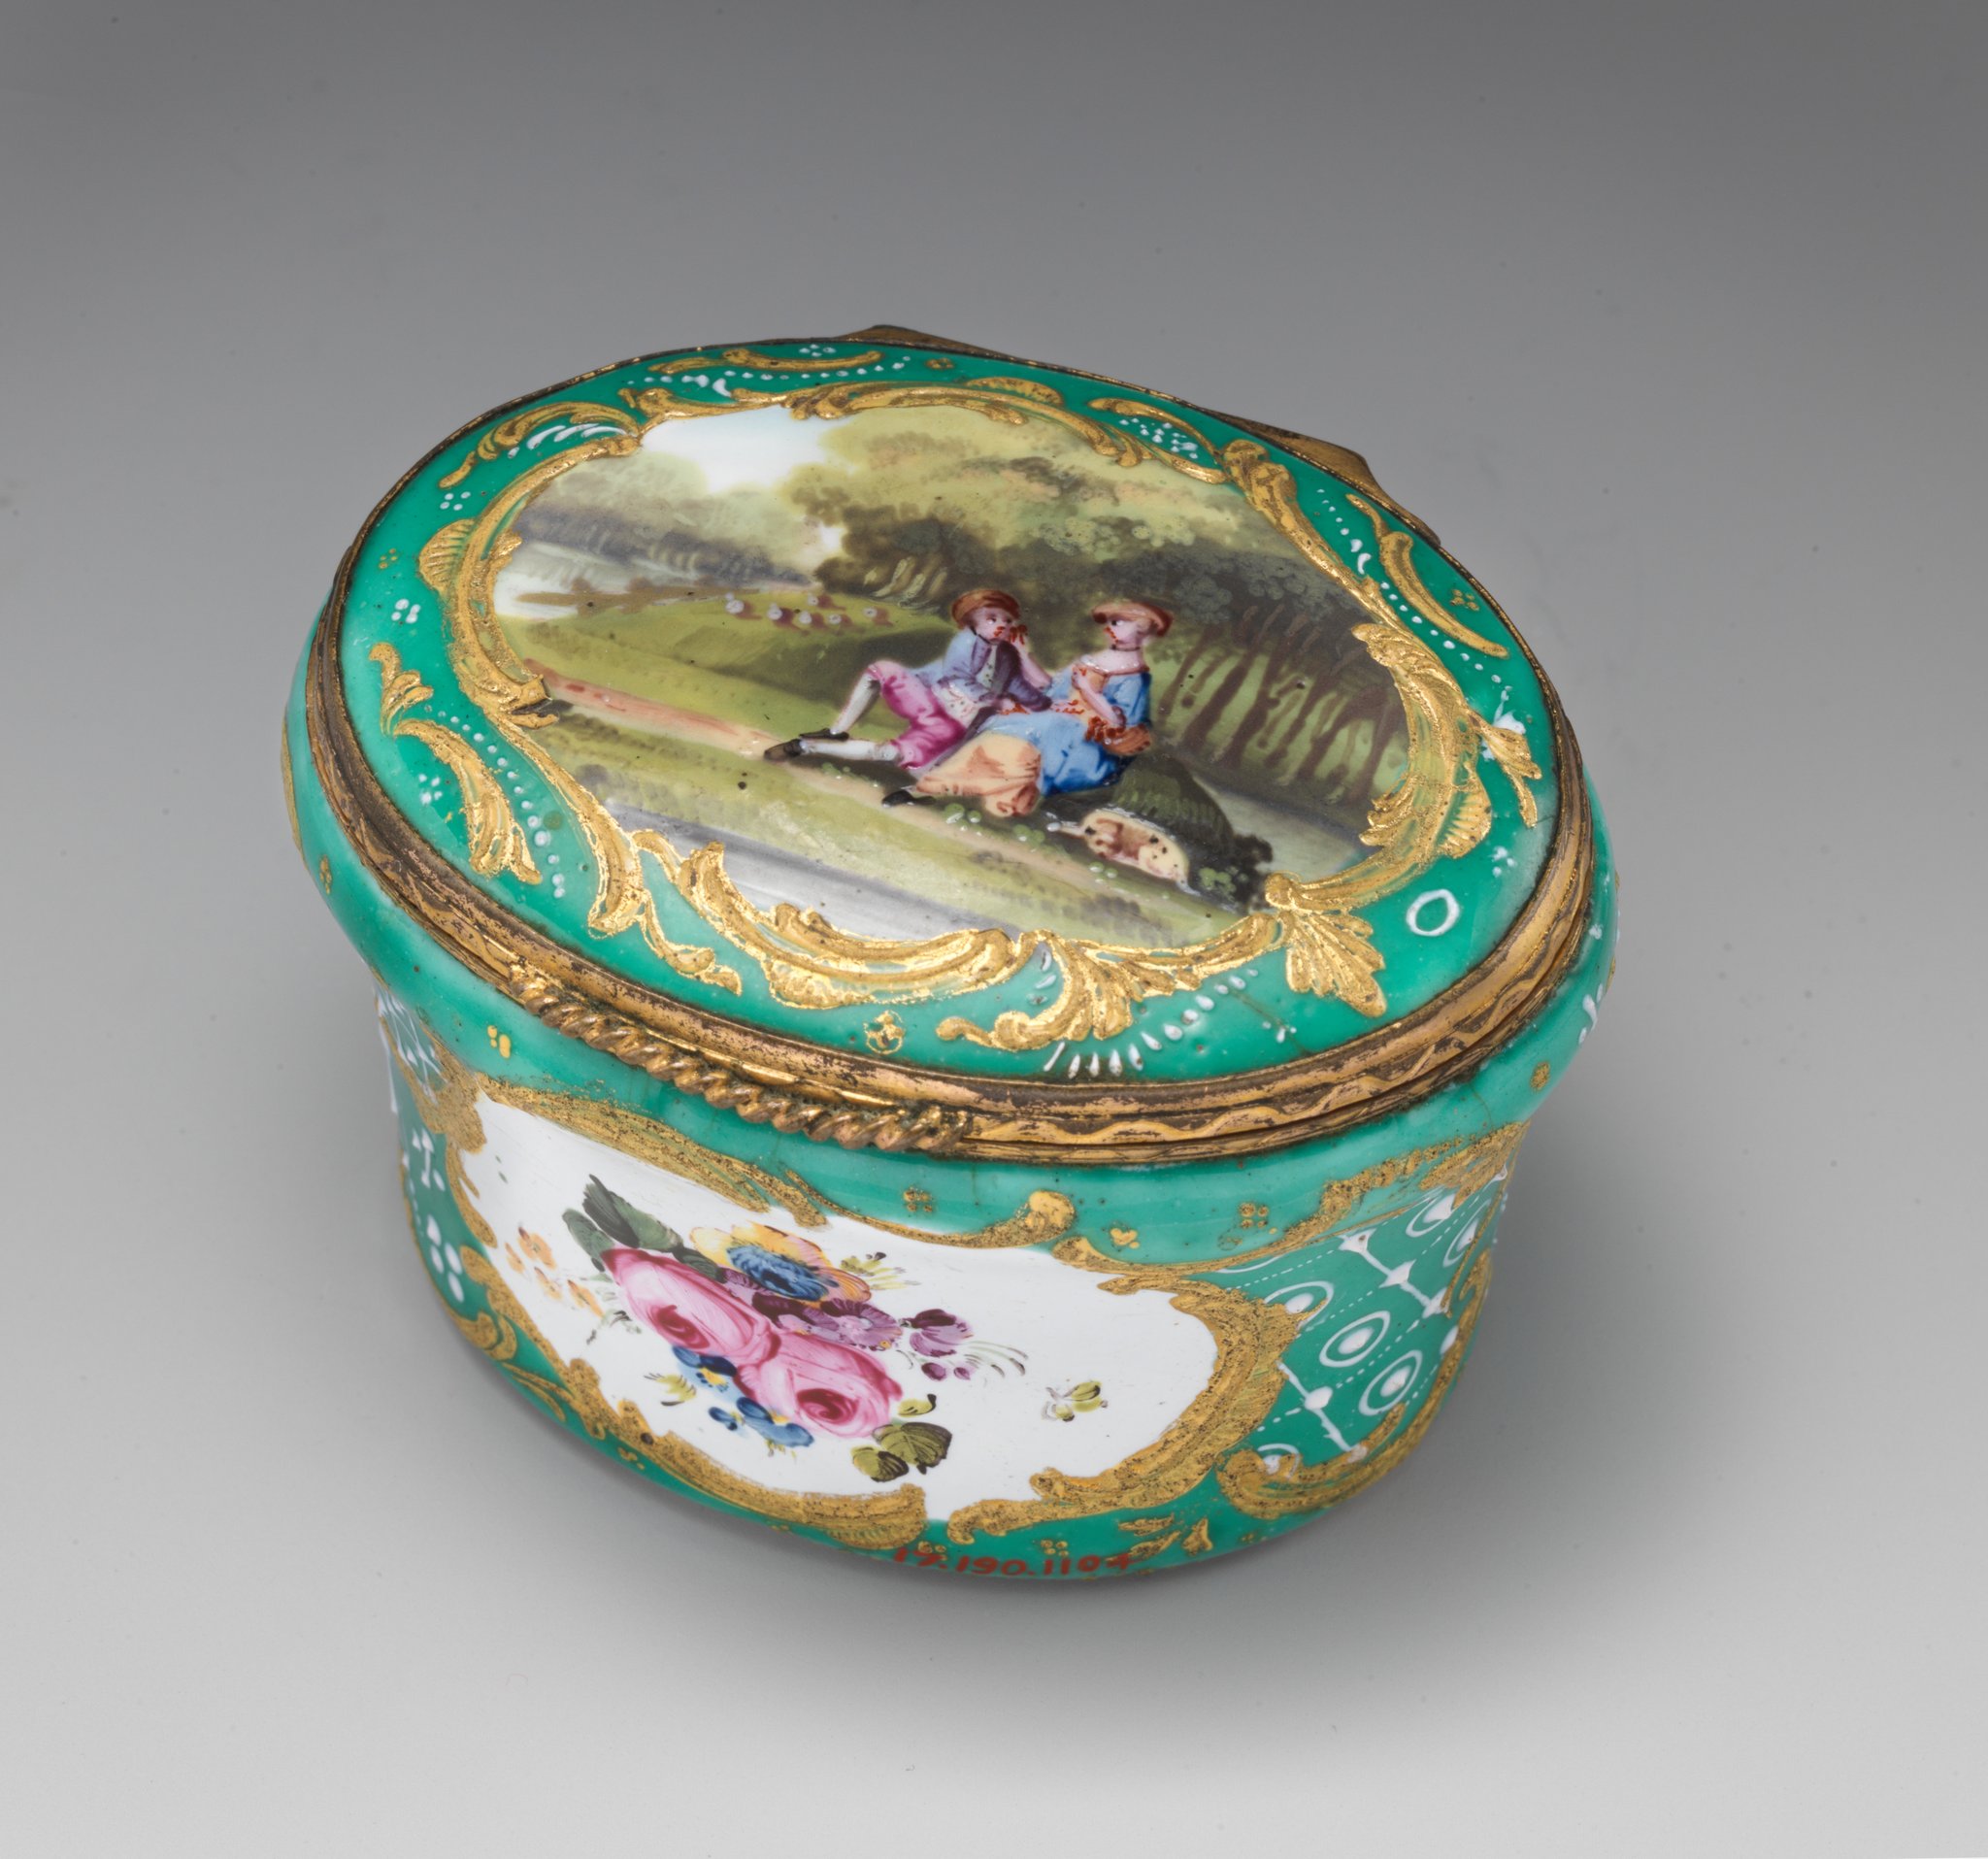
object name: bonbonnière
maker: jacques philippe le bas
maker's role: engraver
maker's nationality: french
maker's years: 1707-1783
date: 1765-1770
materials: copper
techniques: enamel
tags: flowers